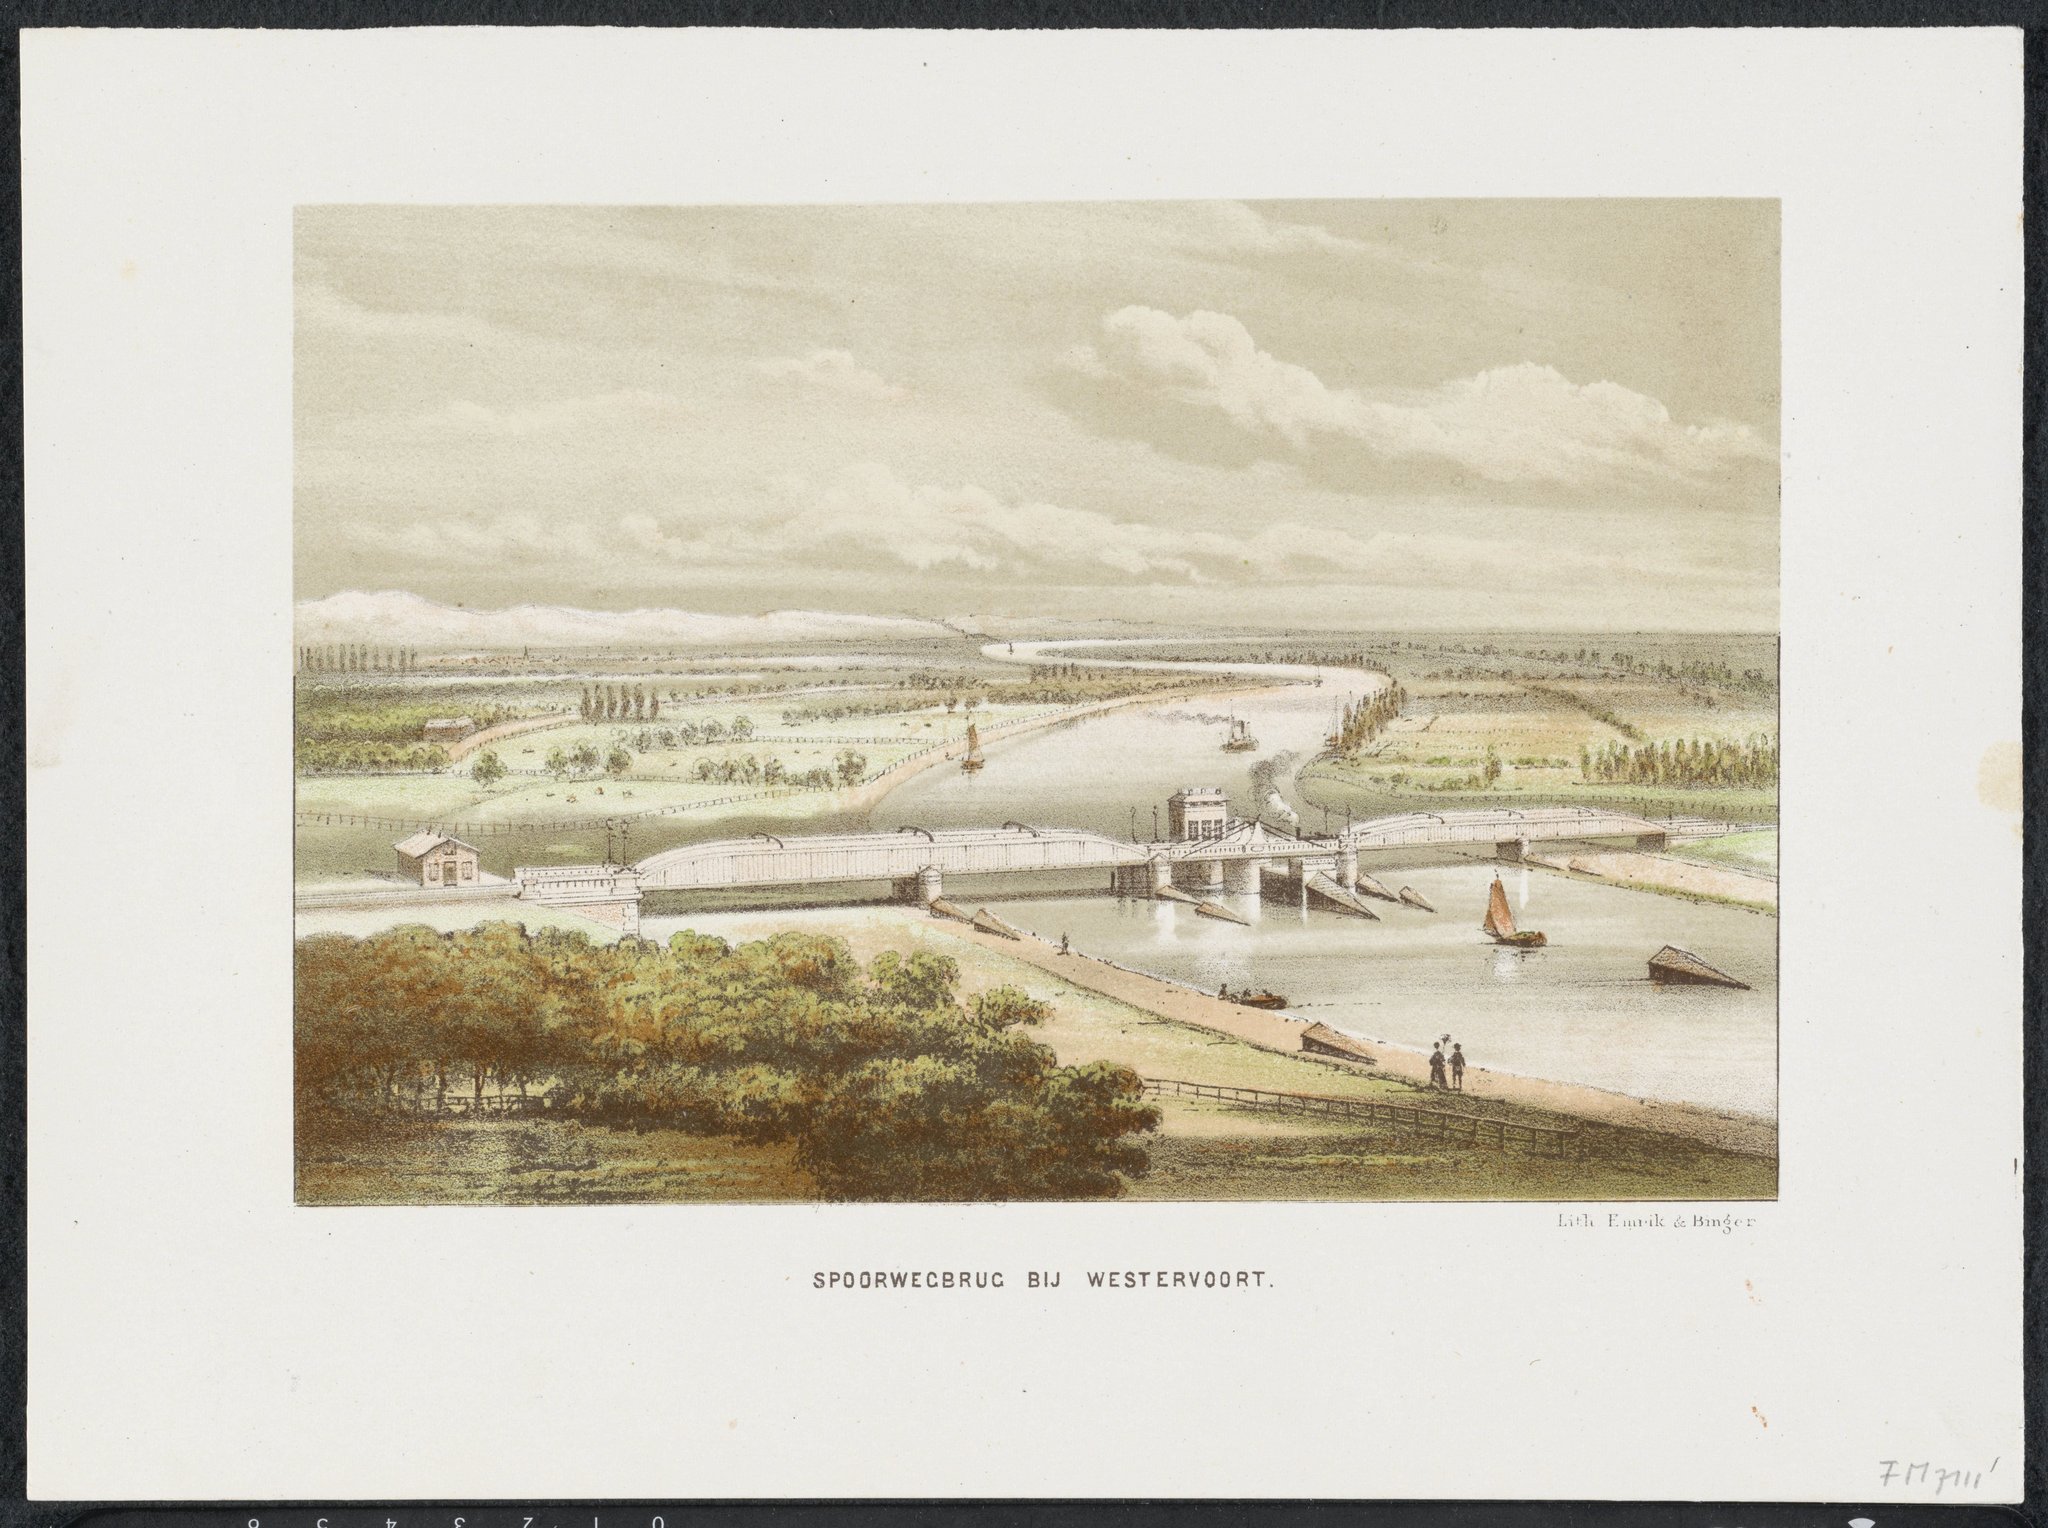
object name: print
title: De Voornaamste Spoorwegbruggen in Nederland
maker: Anonymous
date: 1872-1874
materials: paper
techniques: chromolithography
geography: haarlem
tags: railway, train, bridge, steam locomotive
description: De spoorbrug bij Westervoort, ingewijd op 12 februari 1846. Plaat in een boekje uit 1874 met acht platen van spoorbruggen gebouwd in Nederland uit de jaren 1846-1874.